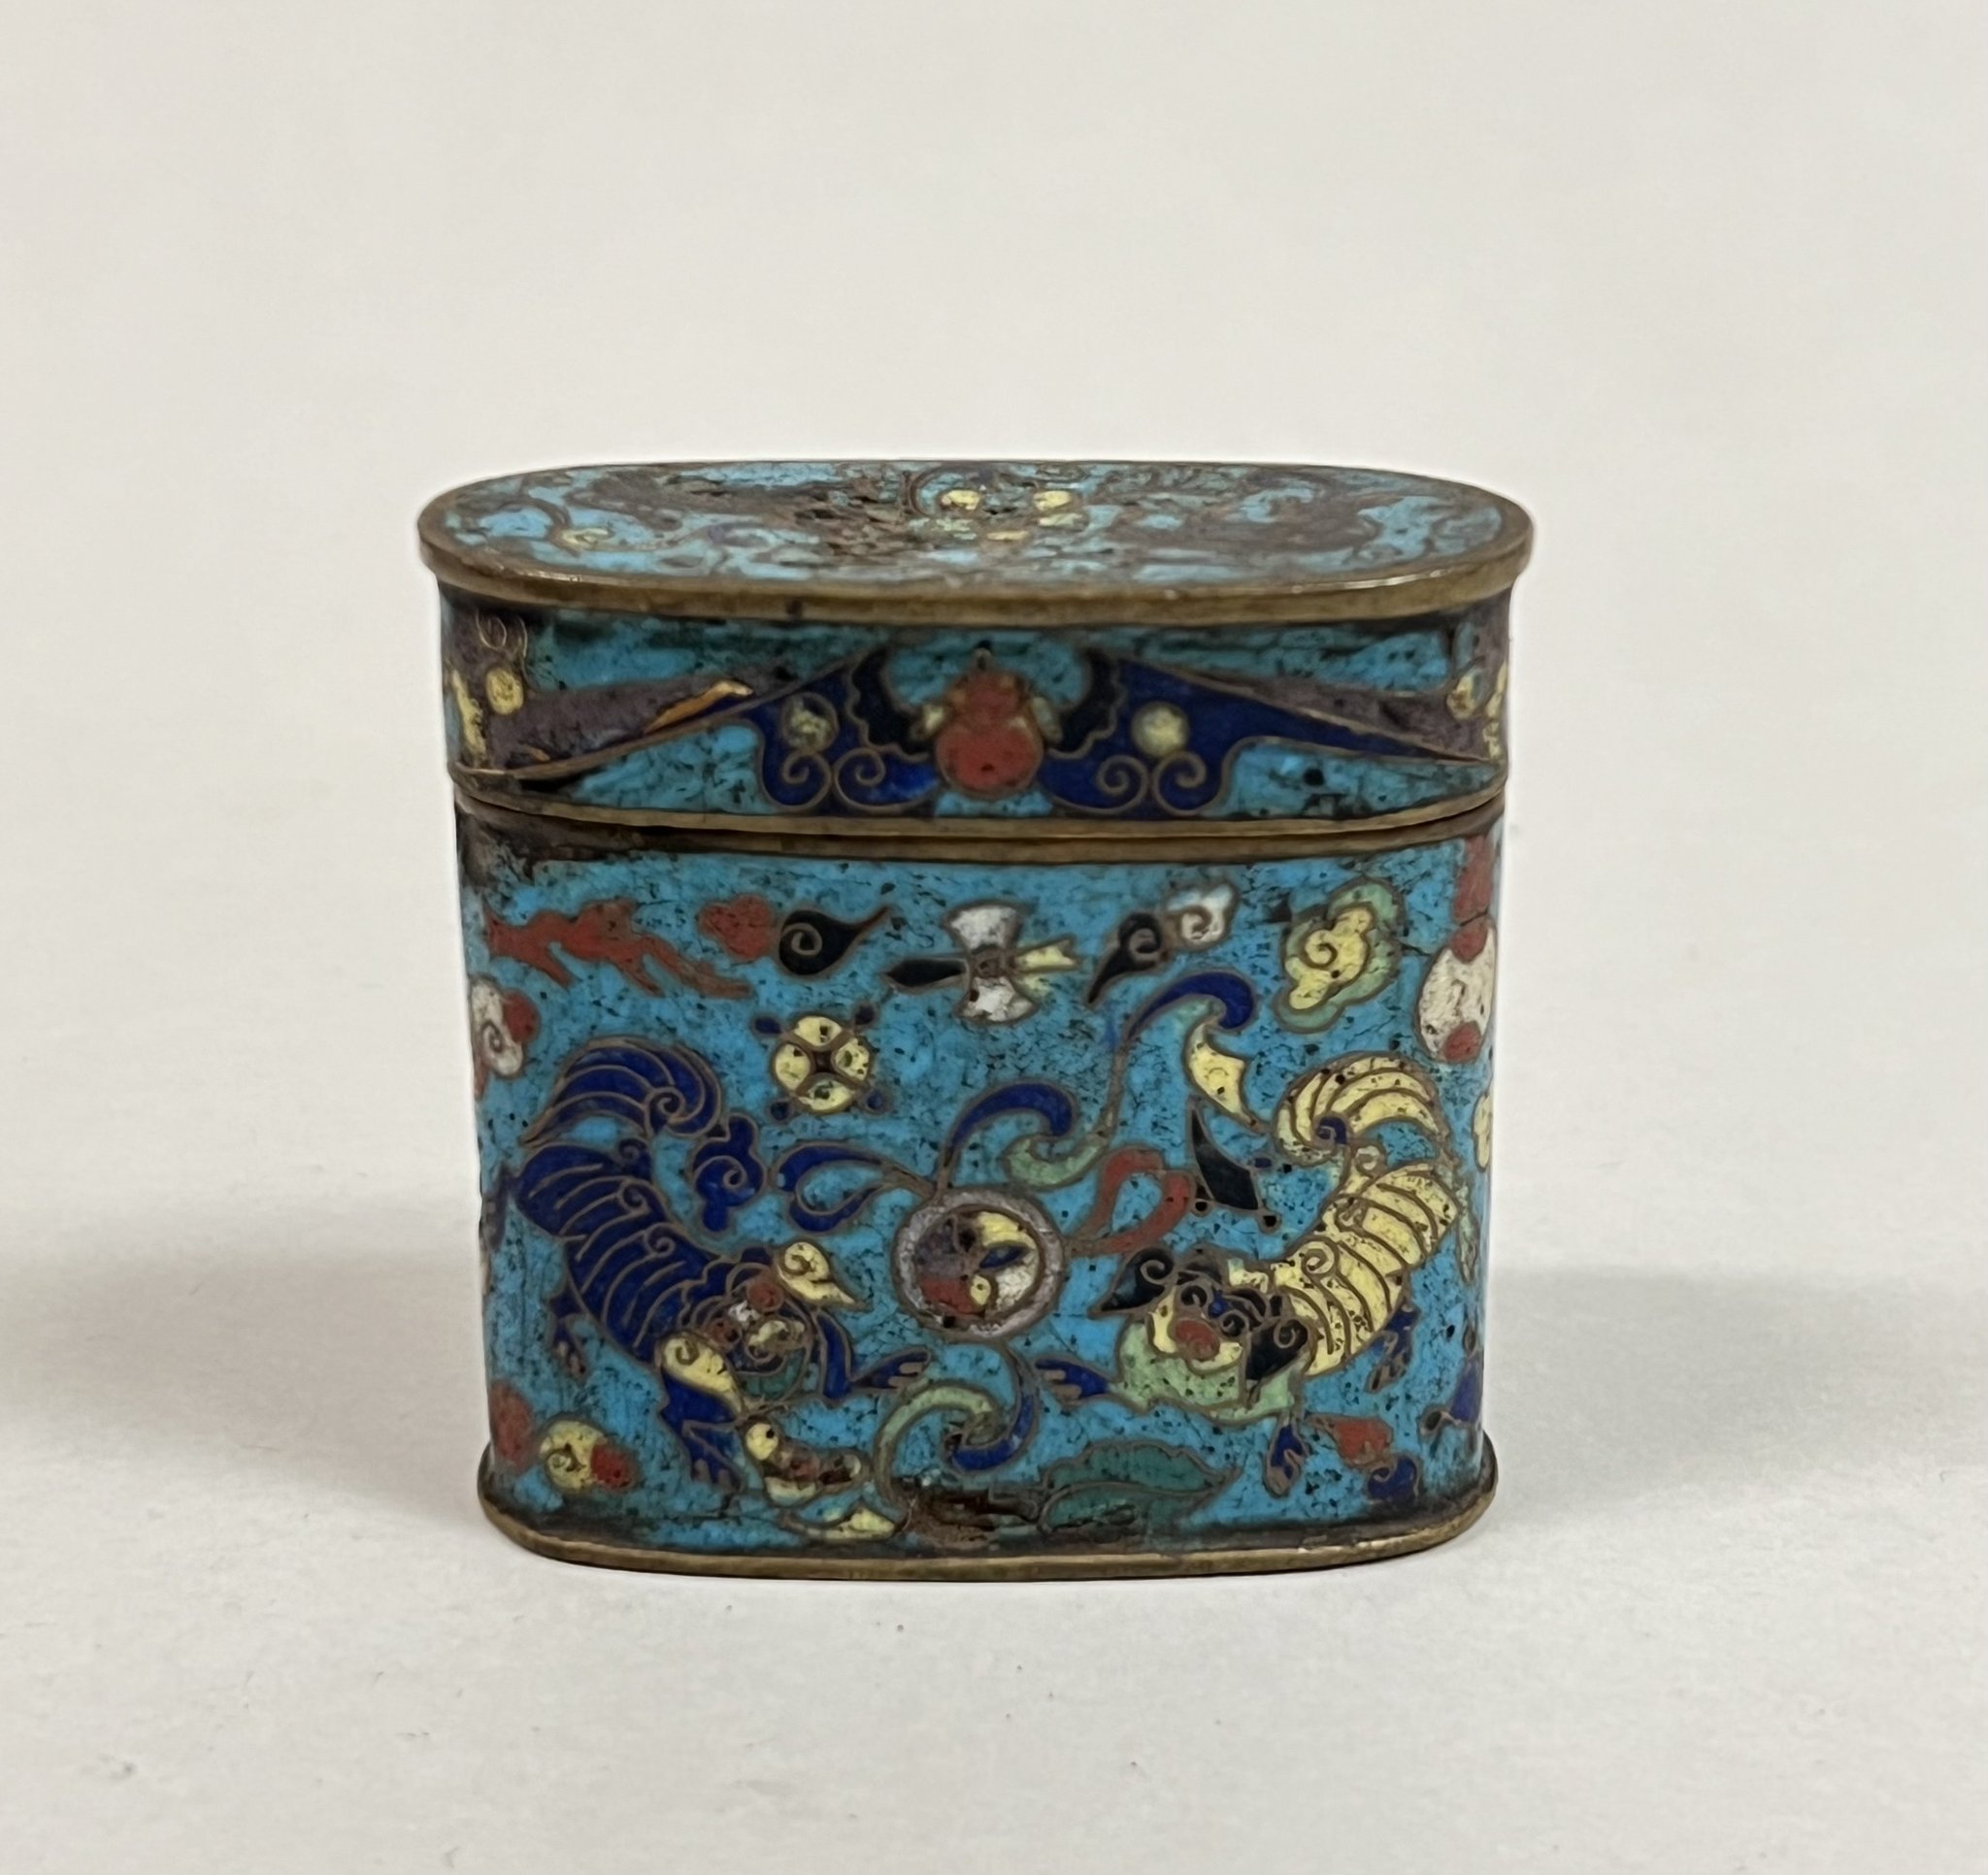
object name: covered box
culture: chinese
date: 1368-1644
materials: enamel, copper gilt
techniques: enamel